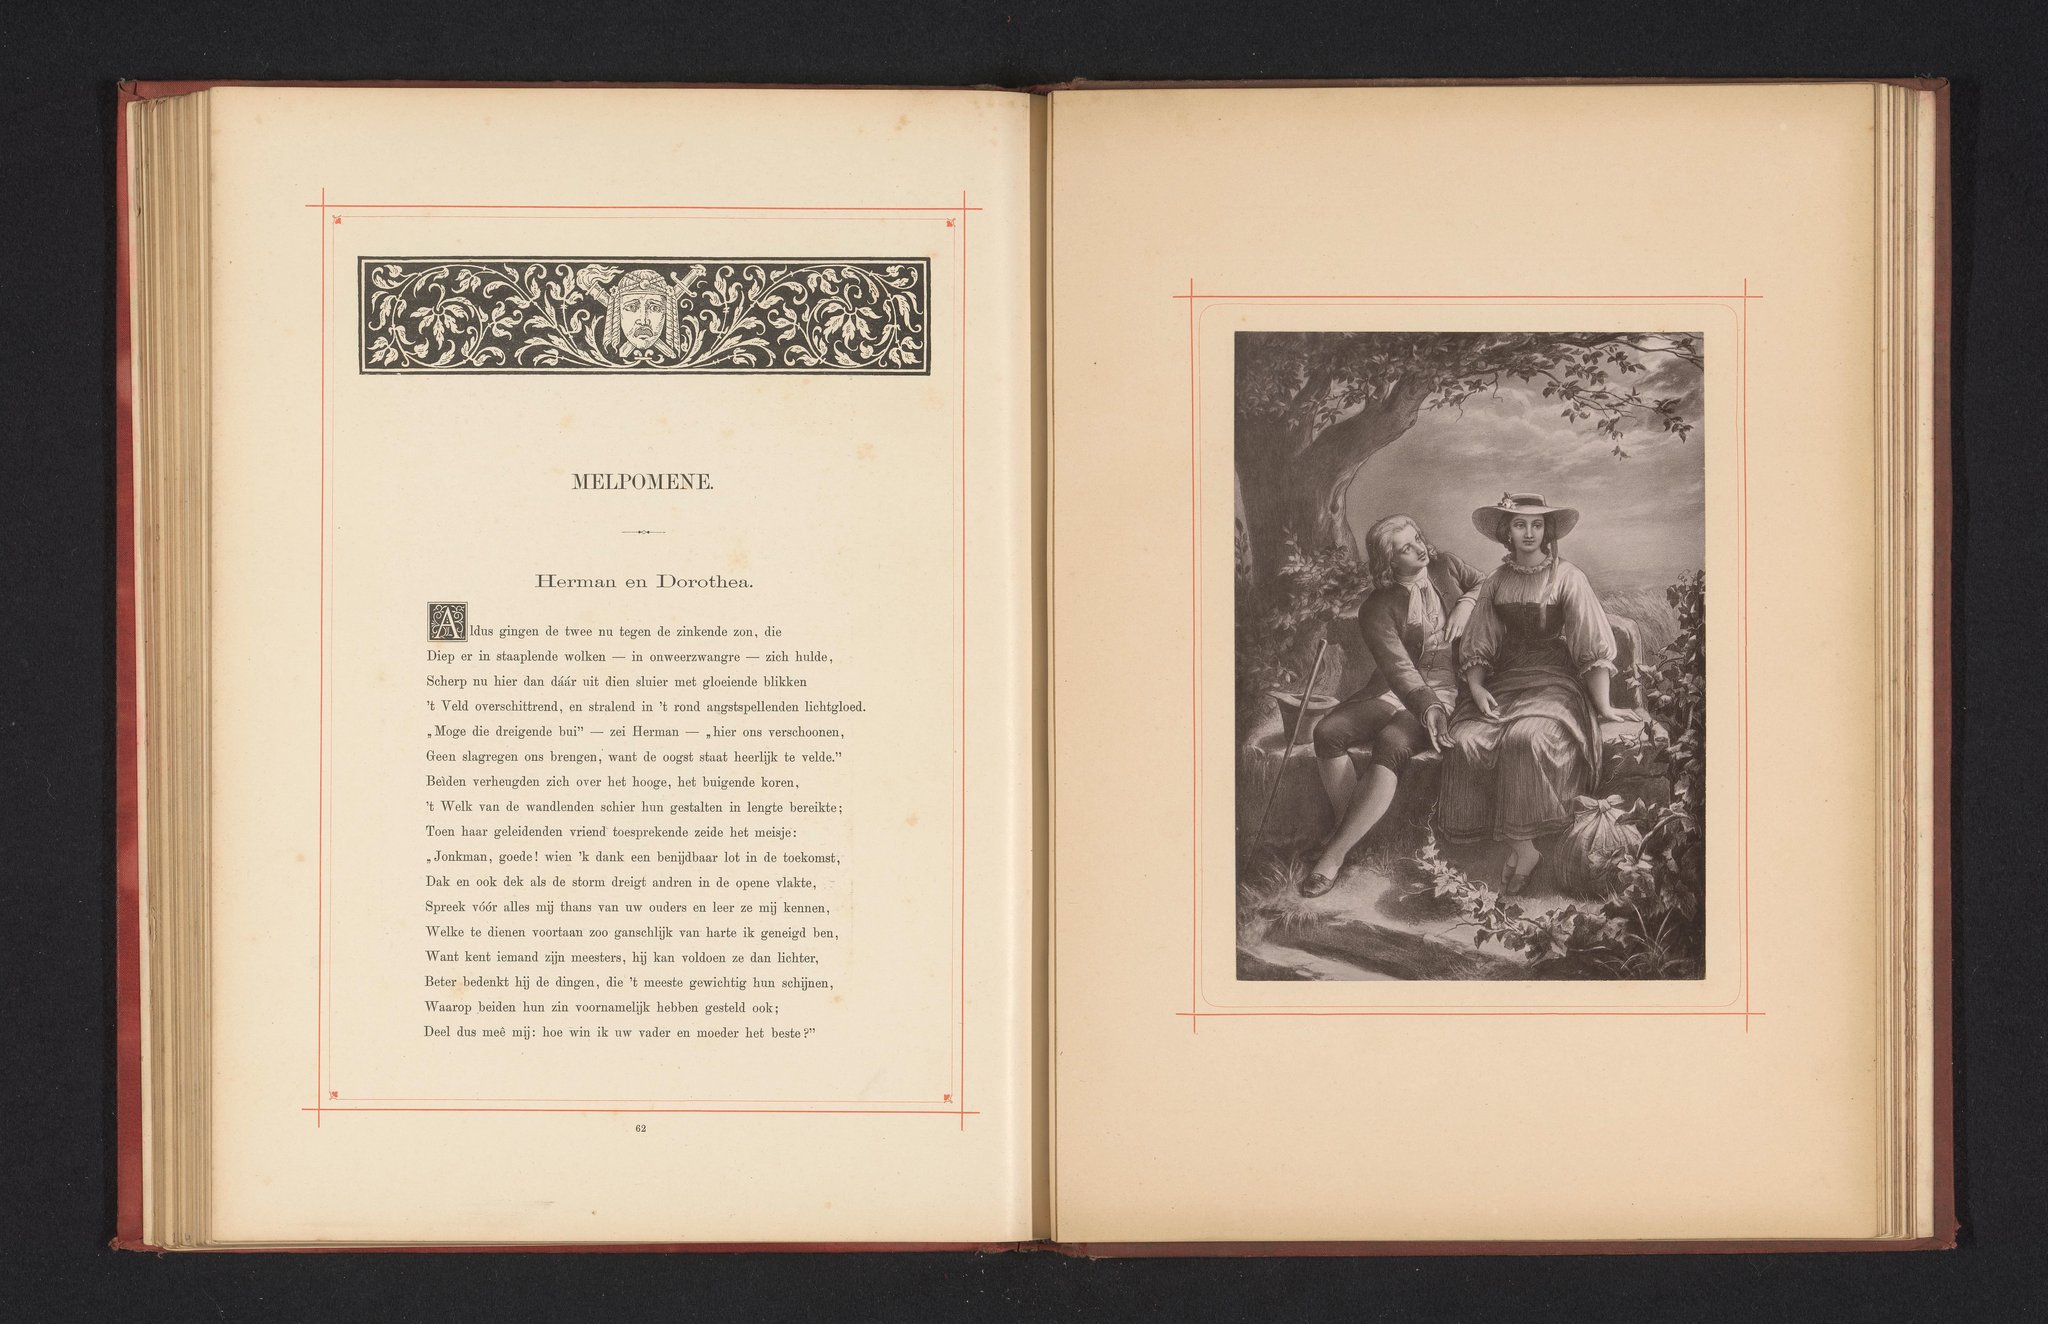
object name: photomechanical print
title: Fotoreproductie van een tekening, voorstellende Herman en Dorothea op een bank onder een boom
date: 1875-1885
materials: paper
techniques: photograph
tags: bench, adult woman, adult man